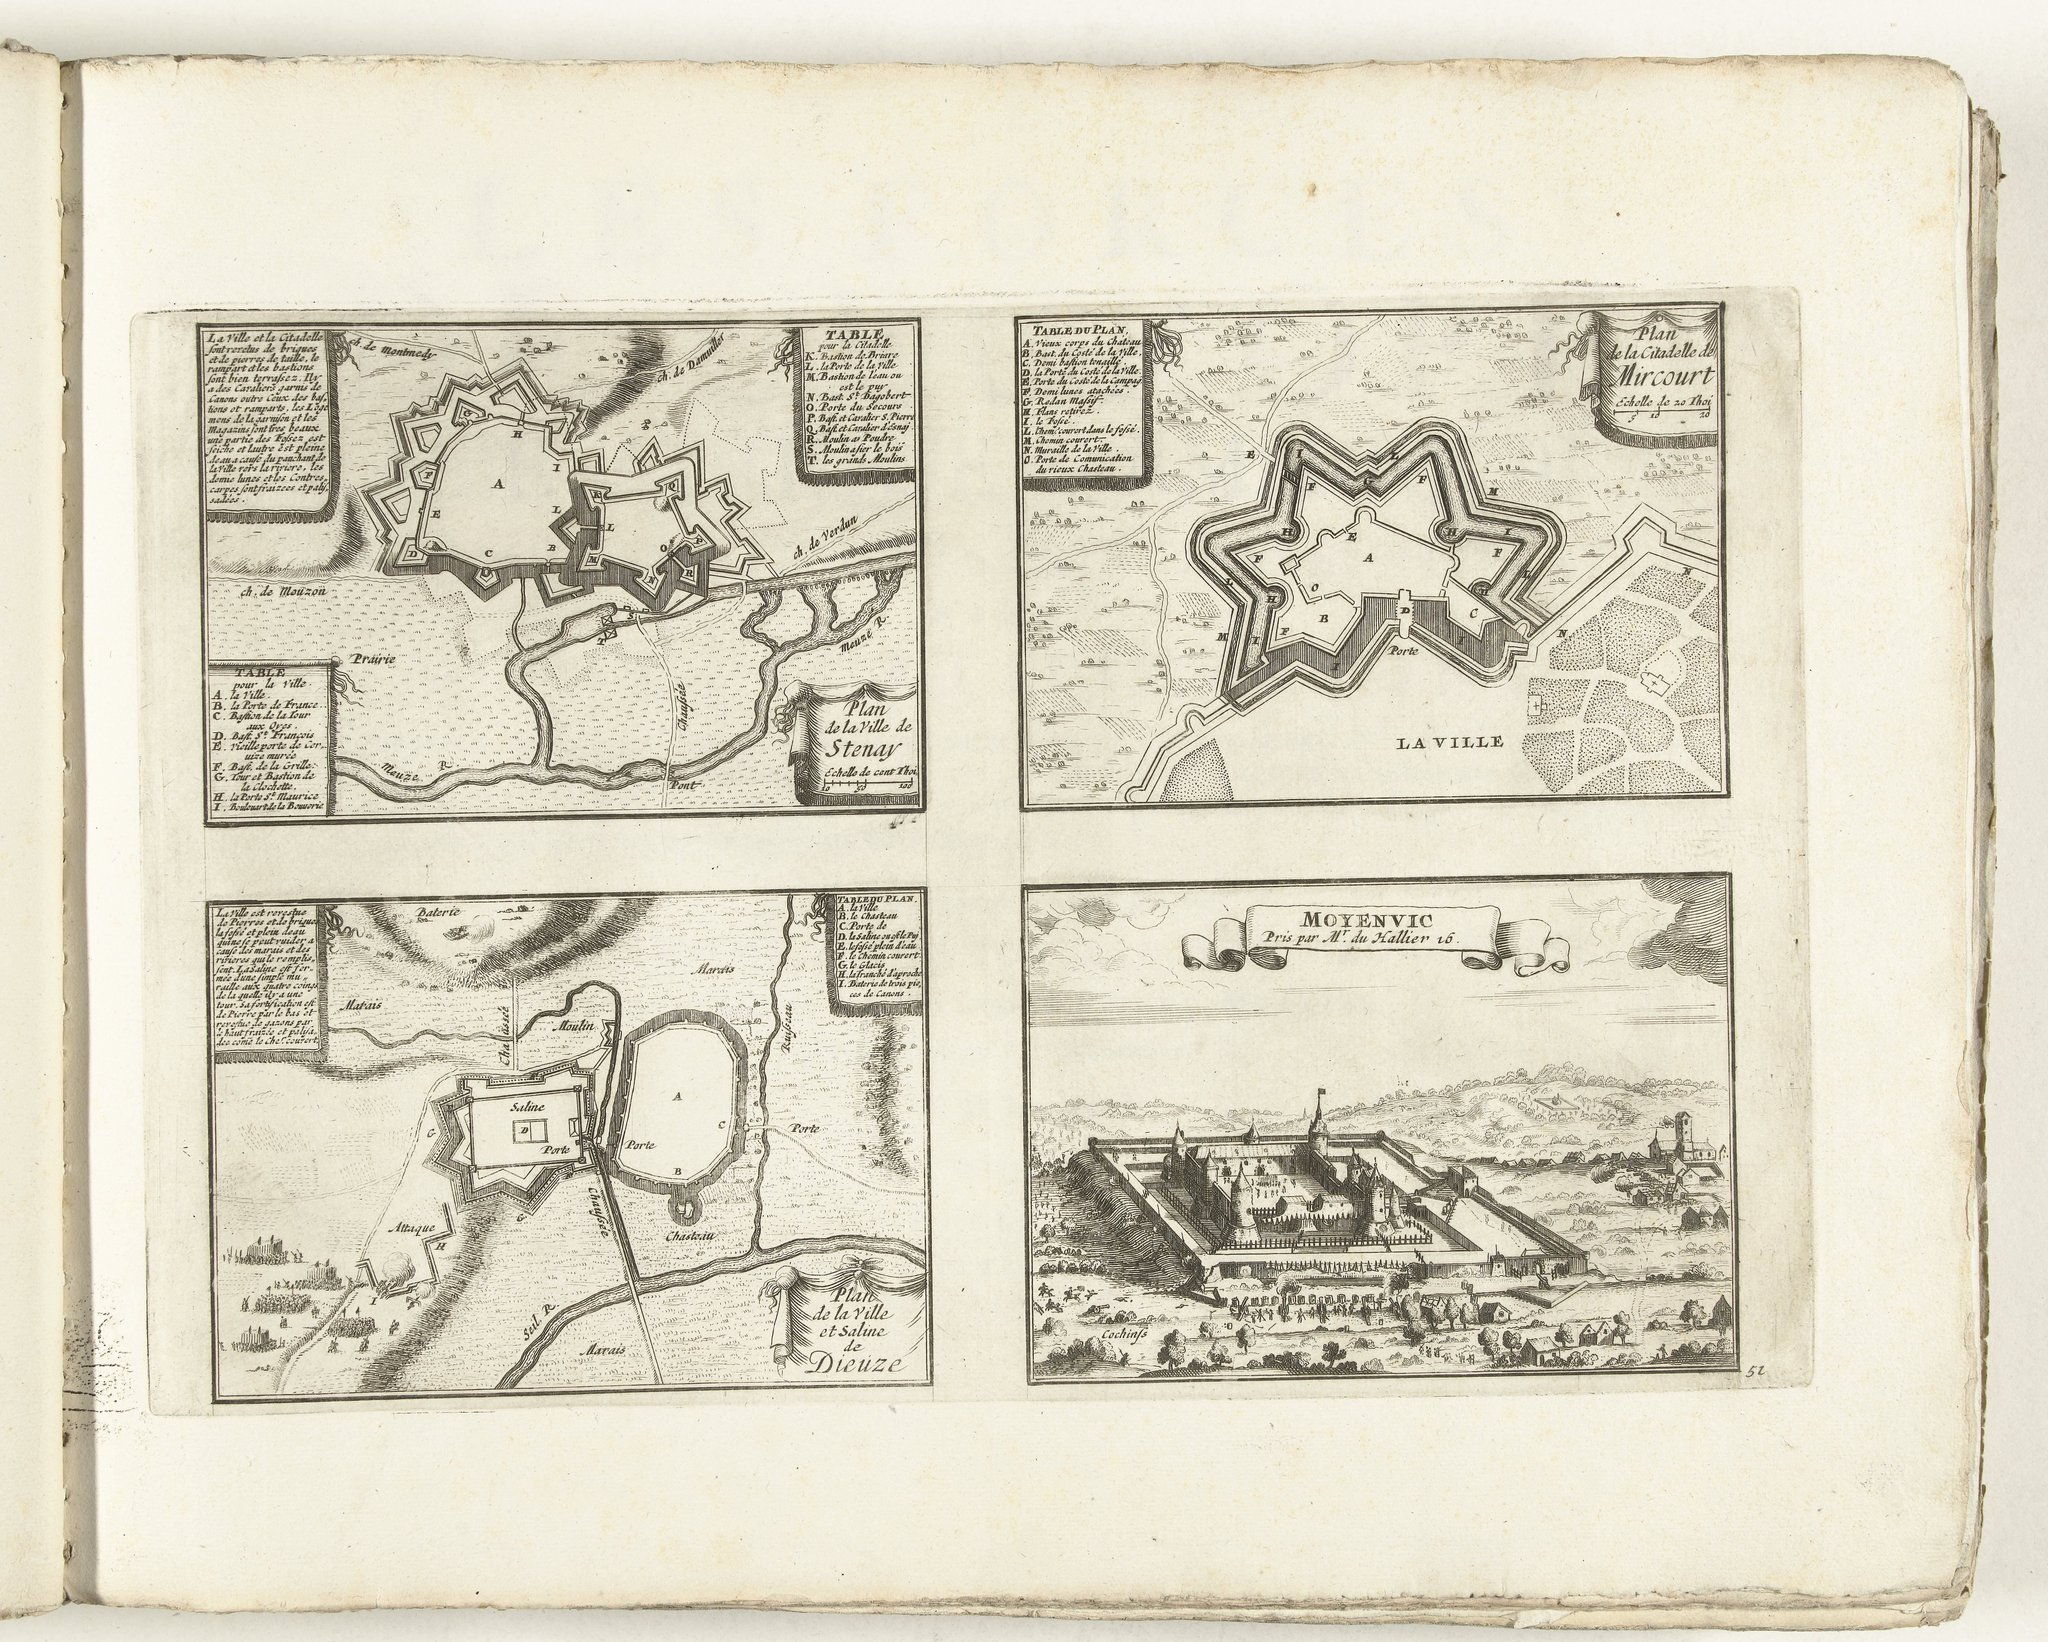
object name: print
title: Stenay / Mircourt / Dieuze / Moyenvic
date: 1702-1703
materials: paper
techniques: etching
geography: northern netherlands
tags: fortress, maps of cities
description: Blad met drie plattegronden van de verdedigingswerken om de plaatsen Stenay, Mirecourt, Dieuze en een gezicht op Moyenvic. Plaat nr. 51 in het prentwerk bestaande in totaal uit 276 genummerde platen van vermaarde sterke steden en vestingen in het kader van de Spaanse Successieoorlog. Voor het merendeel zijn deze platen gekopieerd naar de anonieme Franse platen: in Les forces de l'Europe en in: Le theatre de la guerre, dans les Pays-Bas, beide oorspronkelijk uitgegeven door Nicolas de Fer te Parijs (1693-1697) in het kader van de Negenjarige Oorlog. Titels en opschriften in de plaat in het Frans.